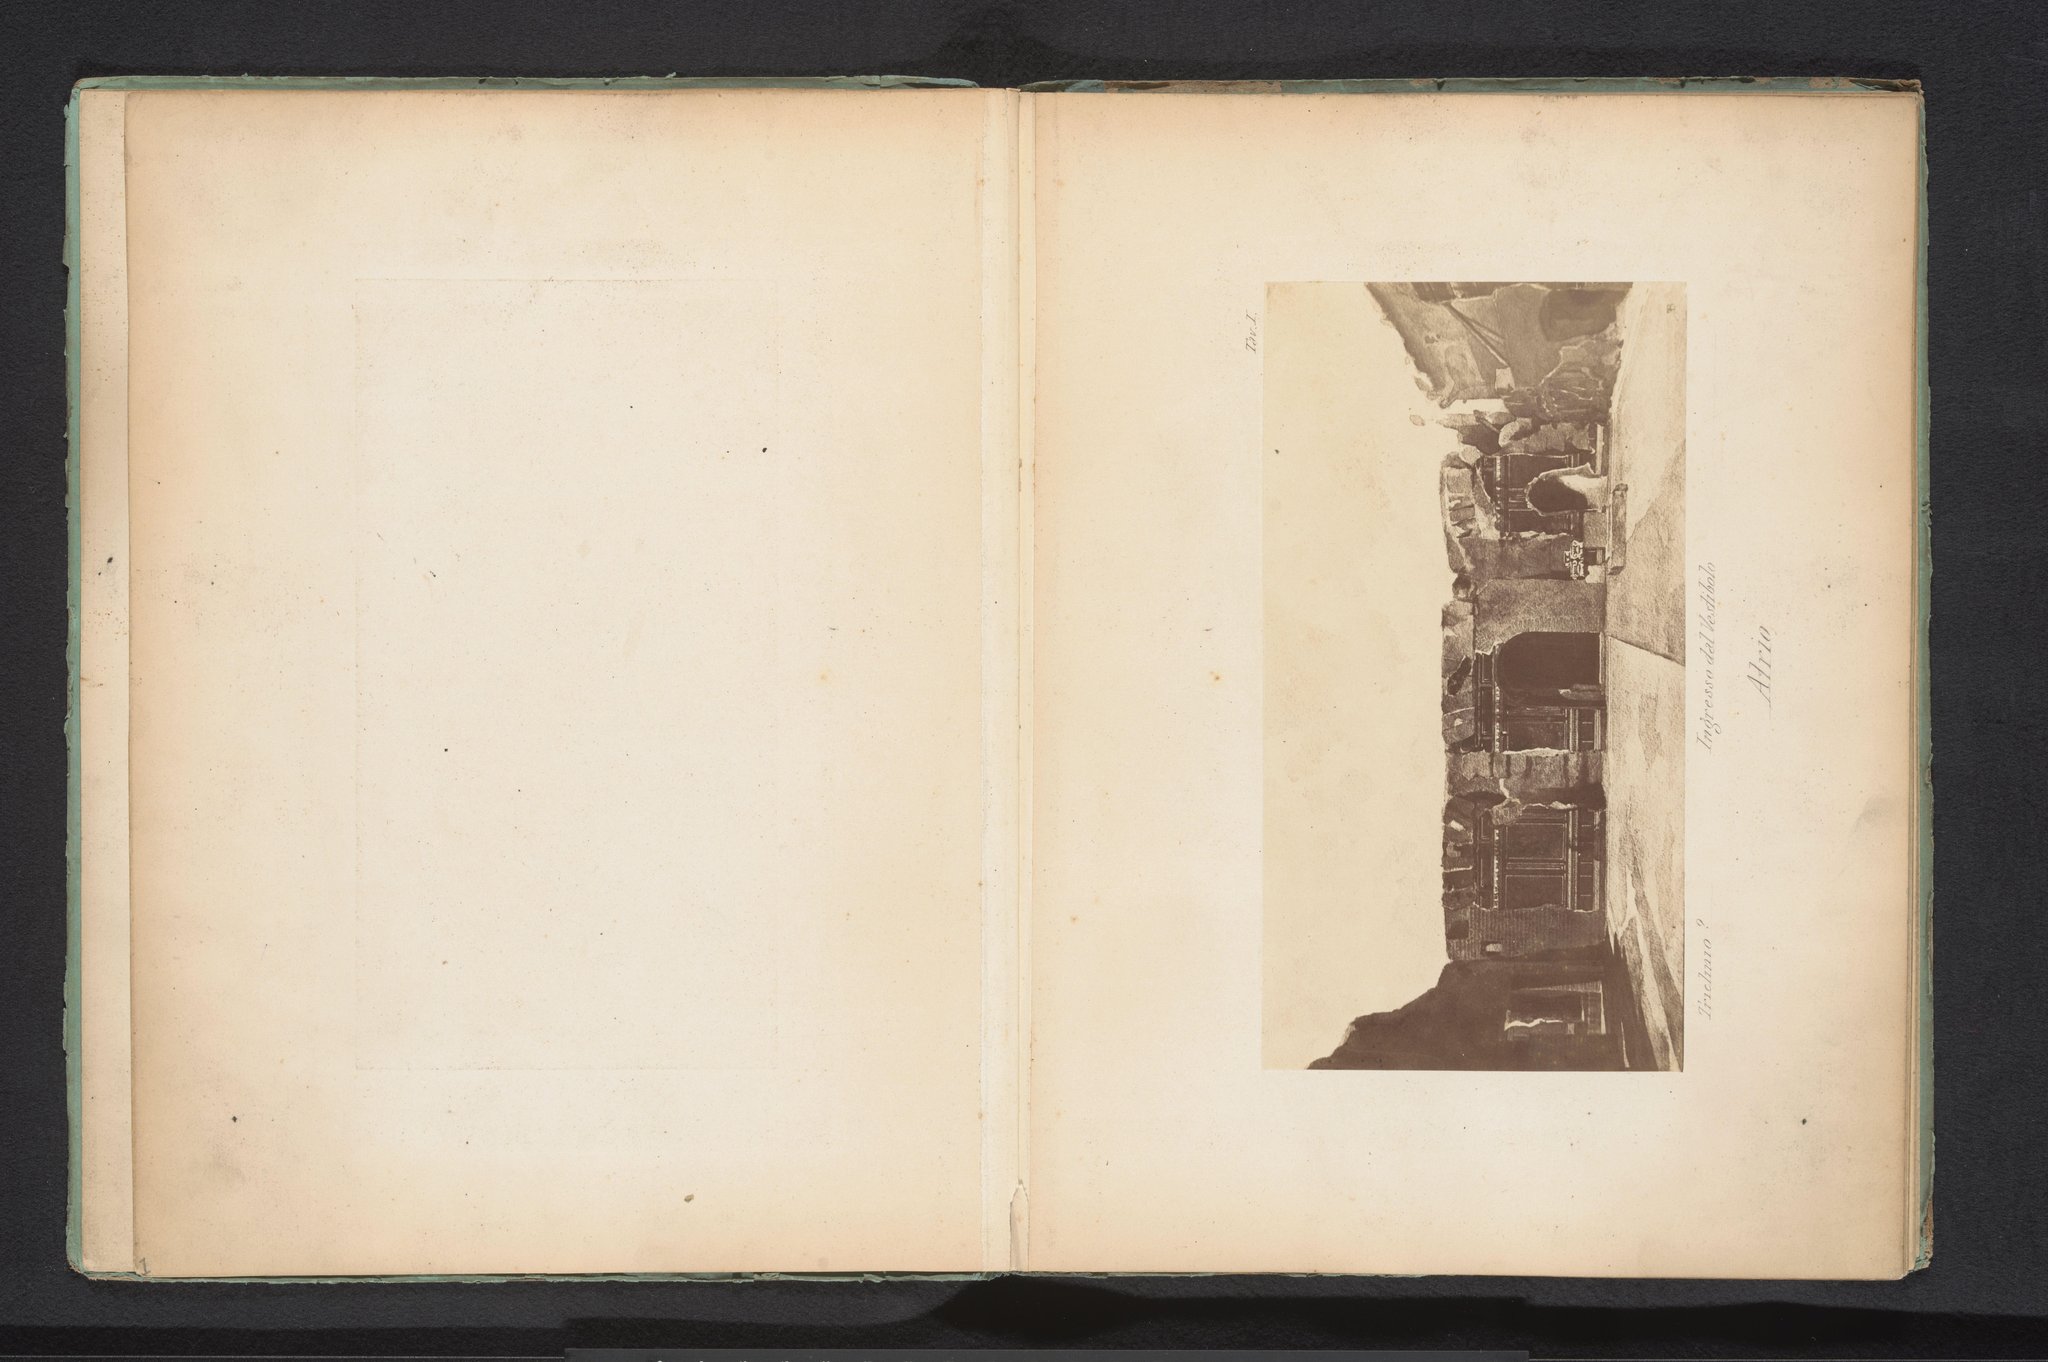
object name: reproduction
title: Triclinio? Ingresso dal Vestibolo Atrio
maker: Anonymous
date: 1859-1869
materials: photographic support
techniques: albumen print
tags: gate, entrance, ruin of a dwelling, house, castle, etc., rome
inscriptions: number: ‘Tav. I.’